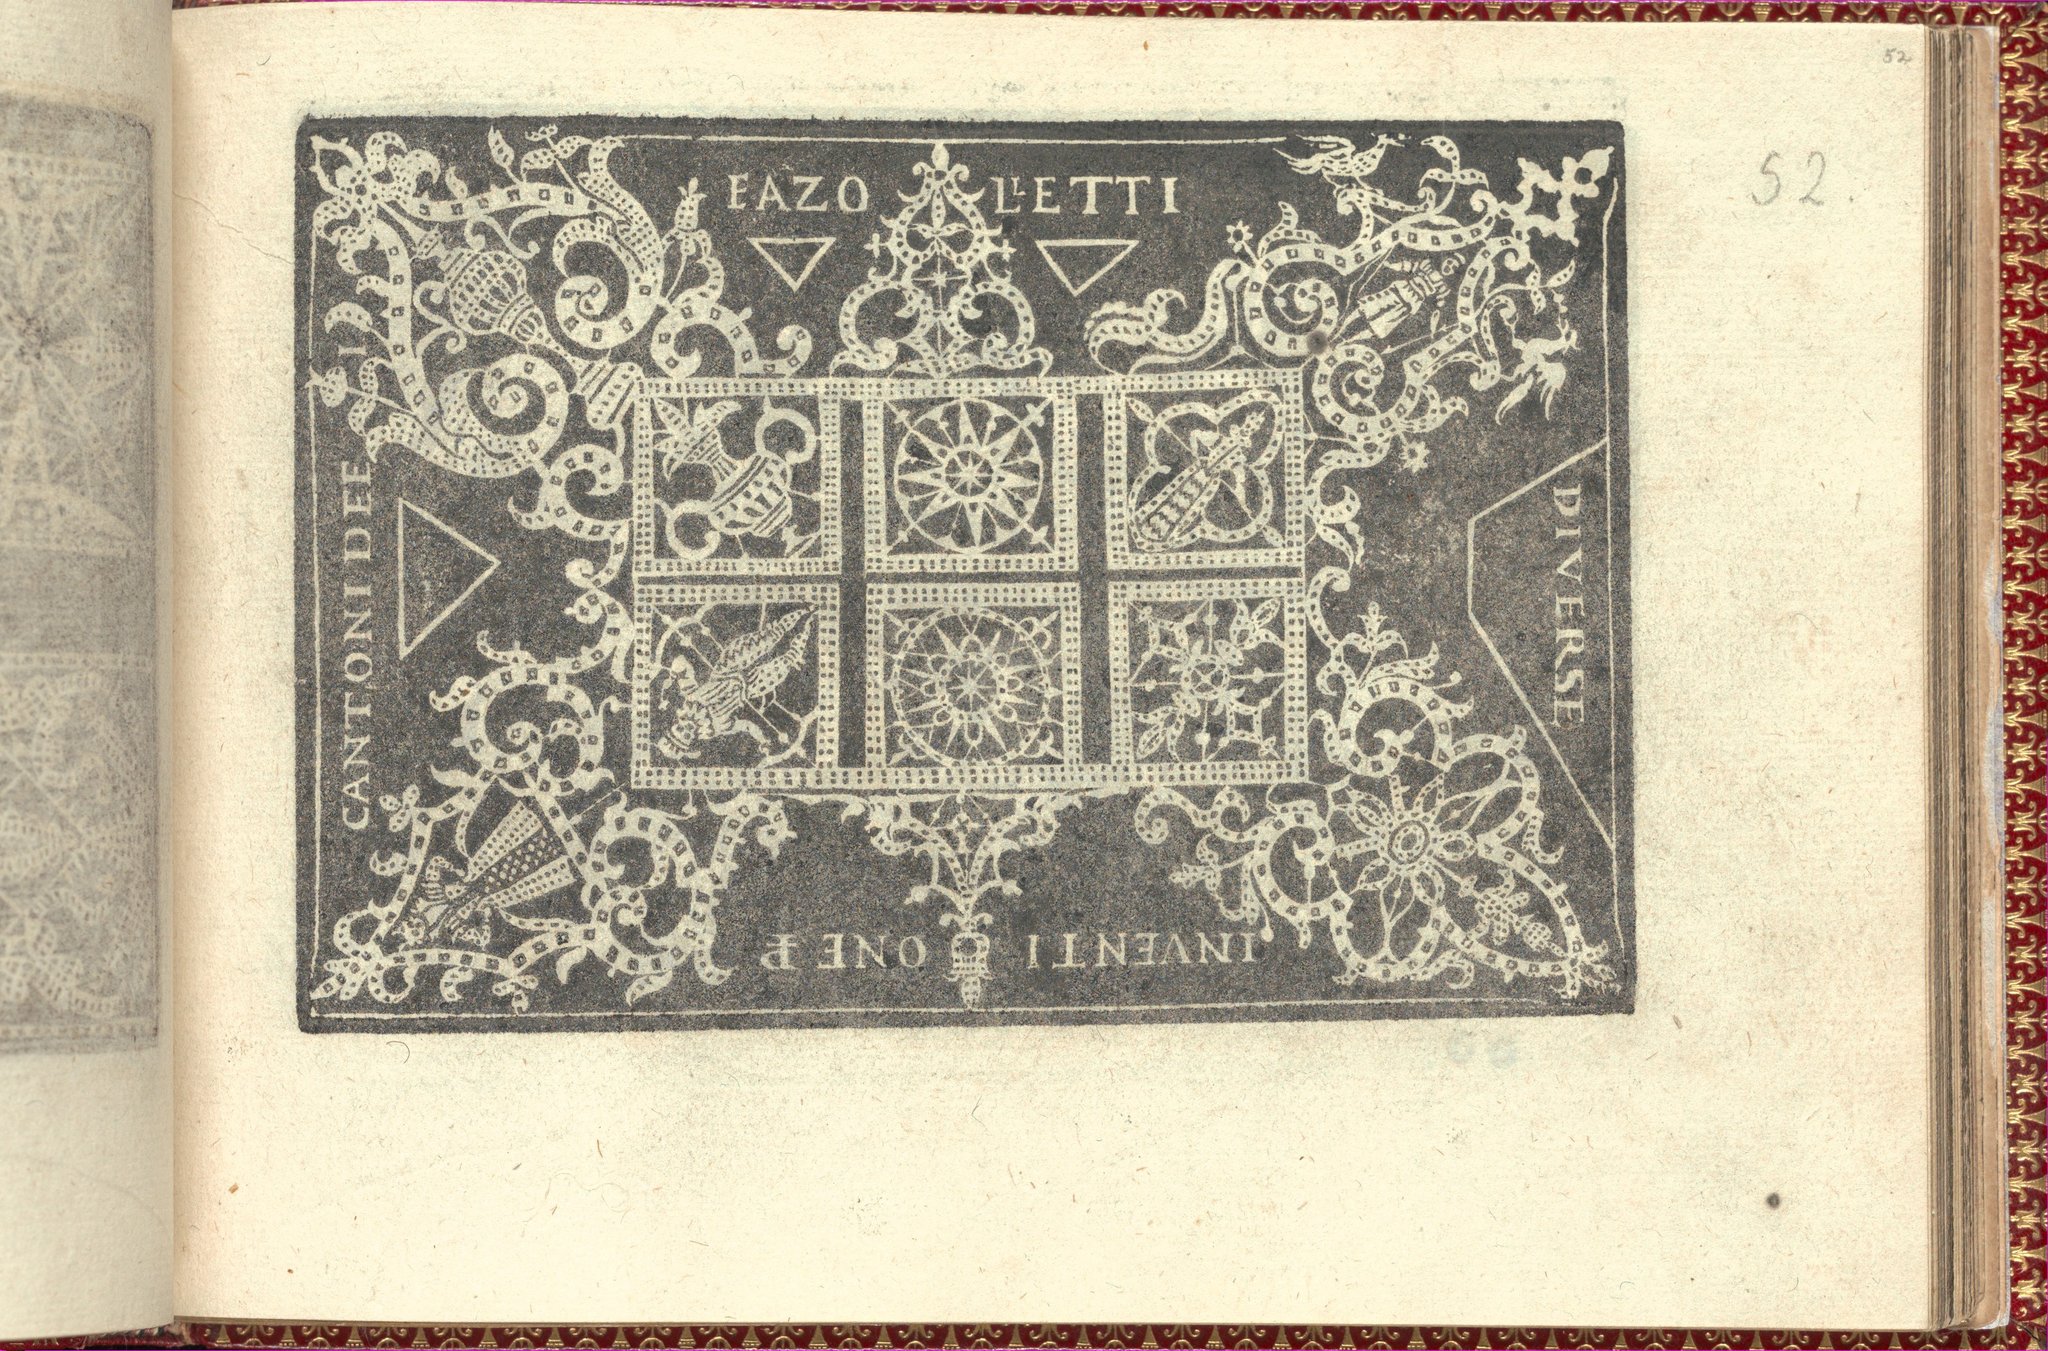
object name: book print ornament architecture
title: Corona delle Nobili et Virtuose Donne: Libro I-IV, page 52 (recto)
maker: cesare vecellio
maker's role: publisher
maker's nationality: italian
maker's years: 1521-1601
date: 1601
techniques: woodcut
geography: italy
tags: ornament